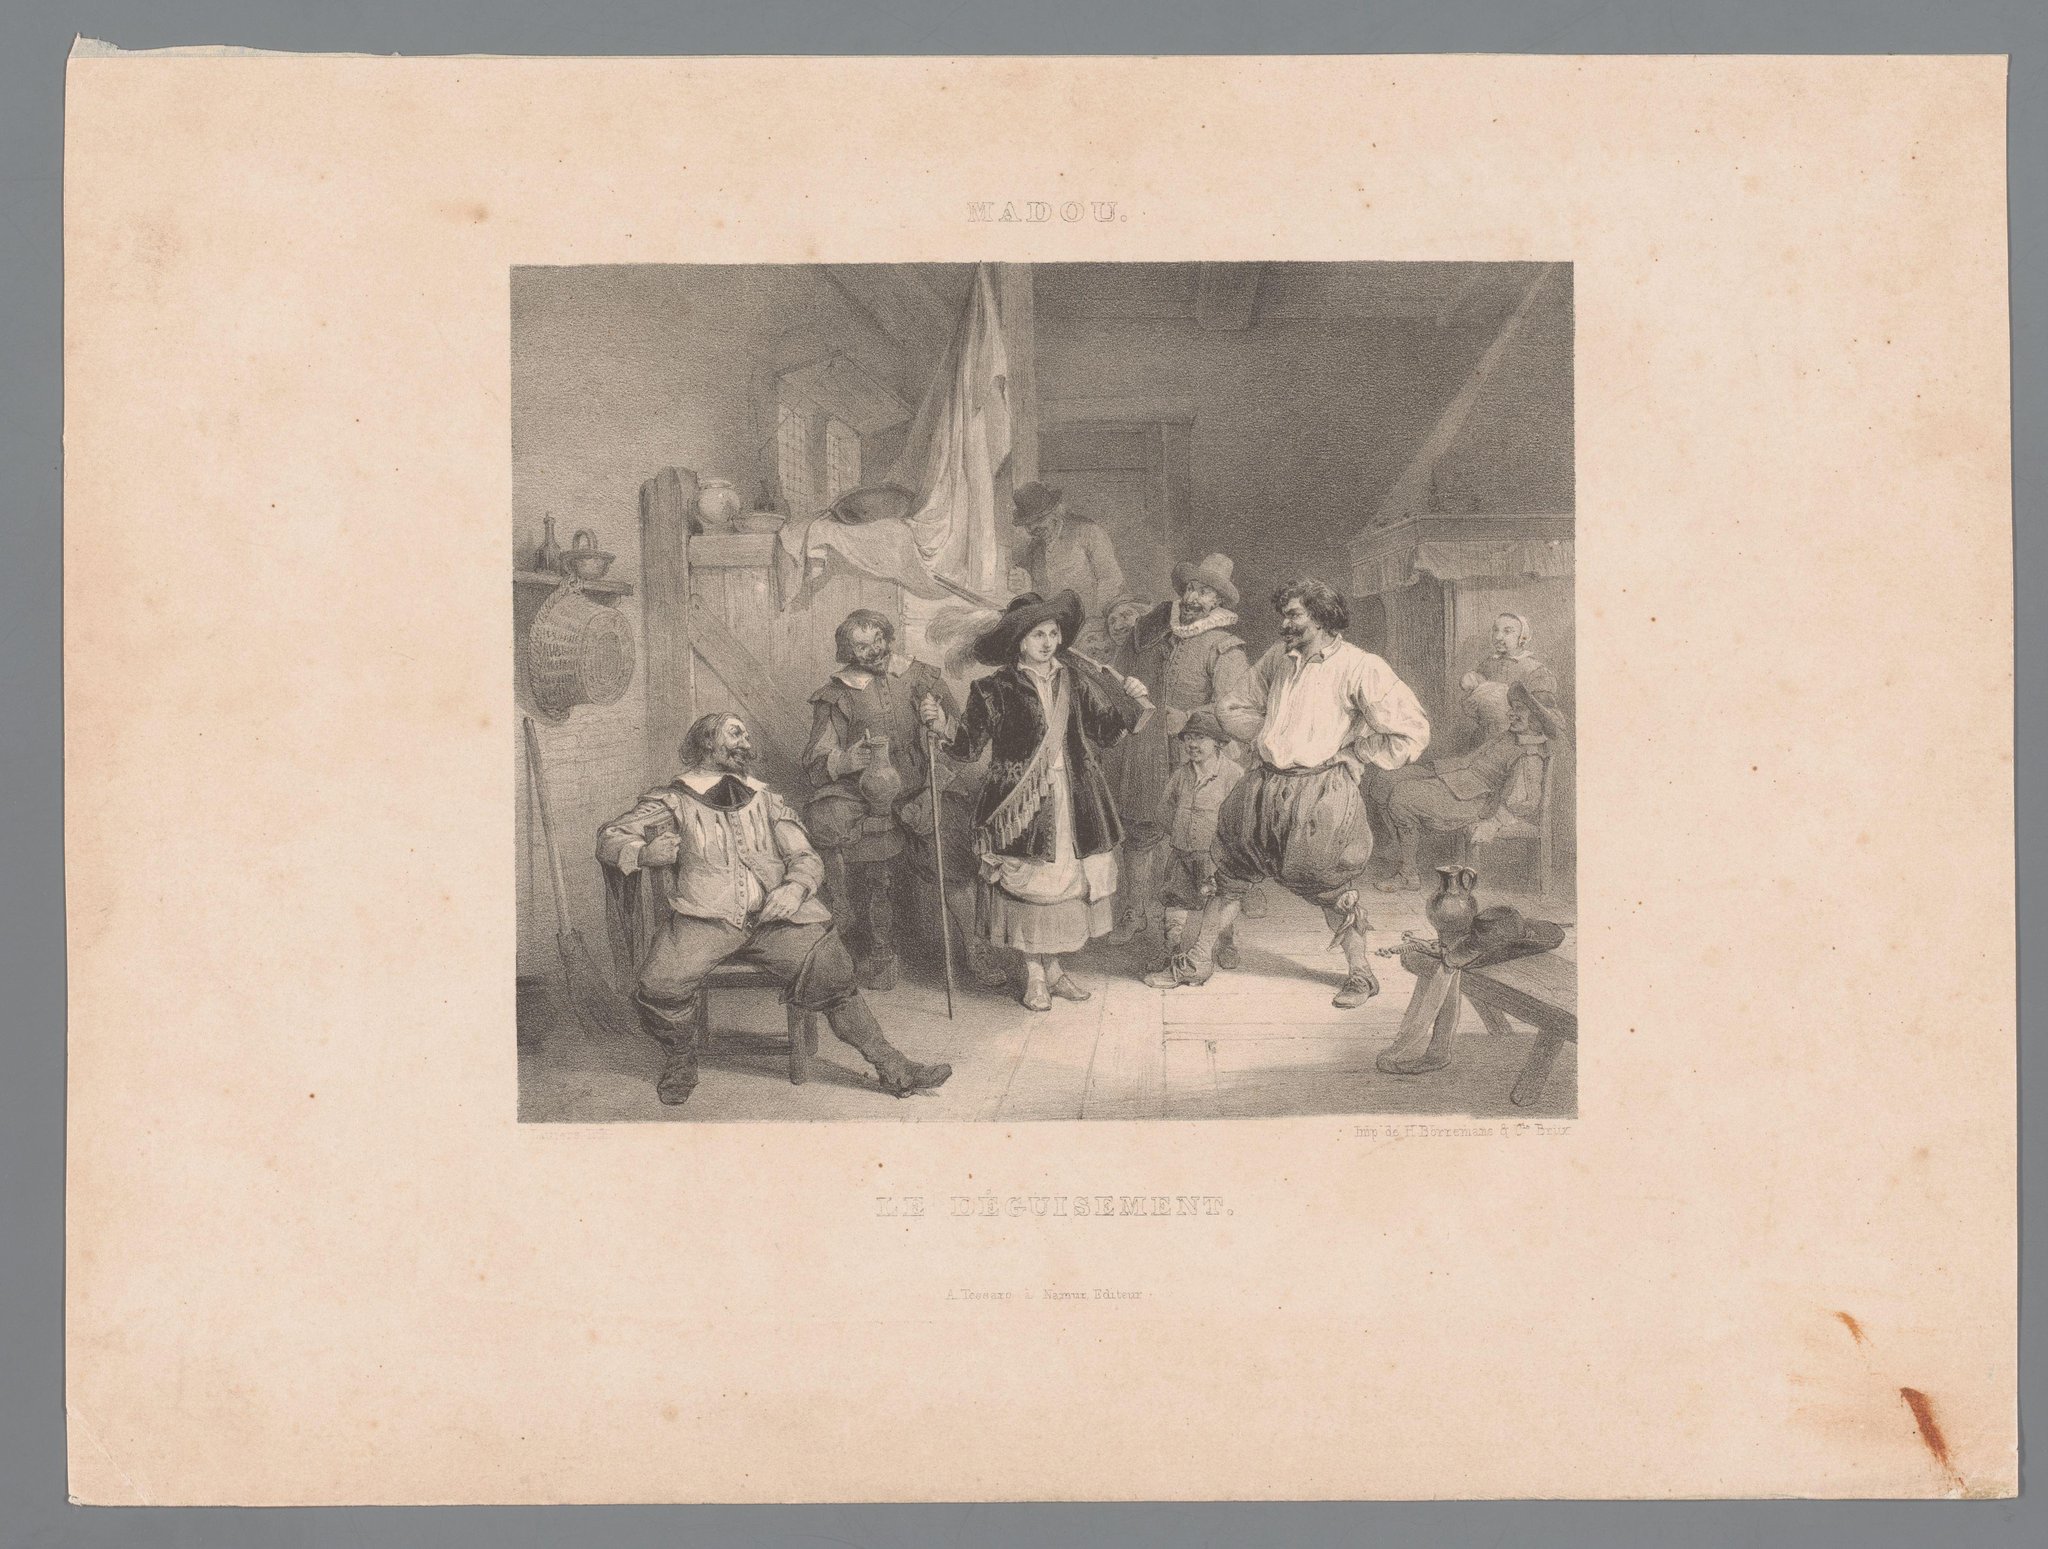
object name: print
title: Madou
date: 1837-1856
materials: paper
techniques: lithograph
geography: brussels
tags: interior of the house, disguise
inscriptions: collector's mark: Lugt 2228